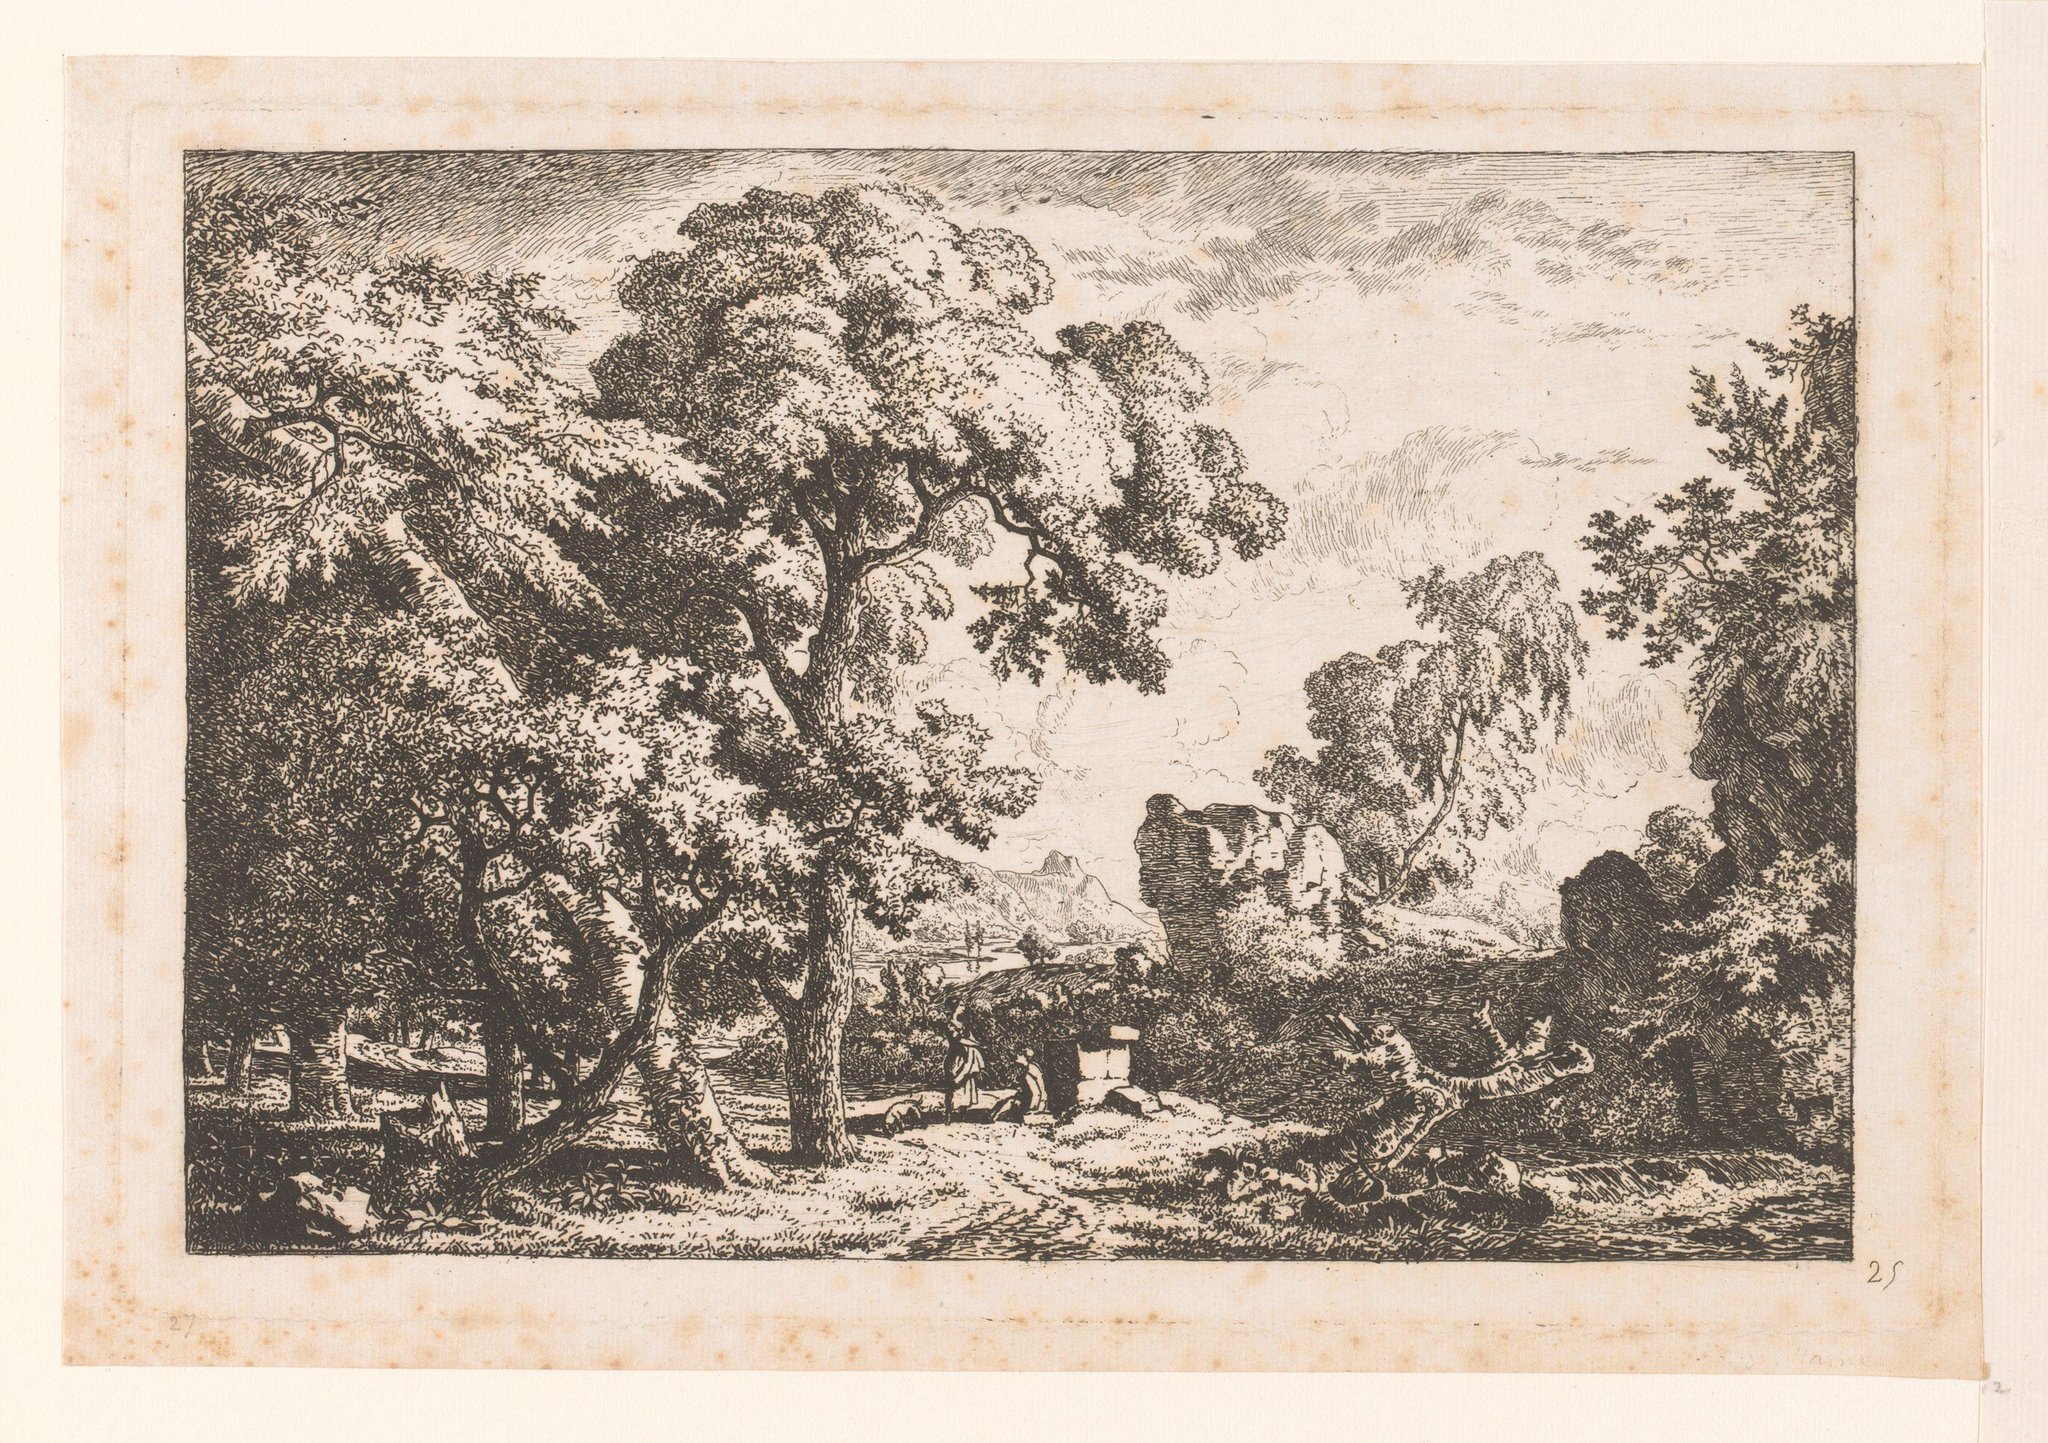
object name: print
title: Landschap met twee figuren bij een rots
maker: jean louis demarne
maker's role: draughtsman, painter, print maker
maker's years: 1752-1829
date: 1762-1829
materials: paper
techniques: etching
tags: rock-formations, landscapes (+ landscape with figures, staffage)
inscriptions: collector's mark: Lugt 2228, collector's mark: Lugt 1485